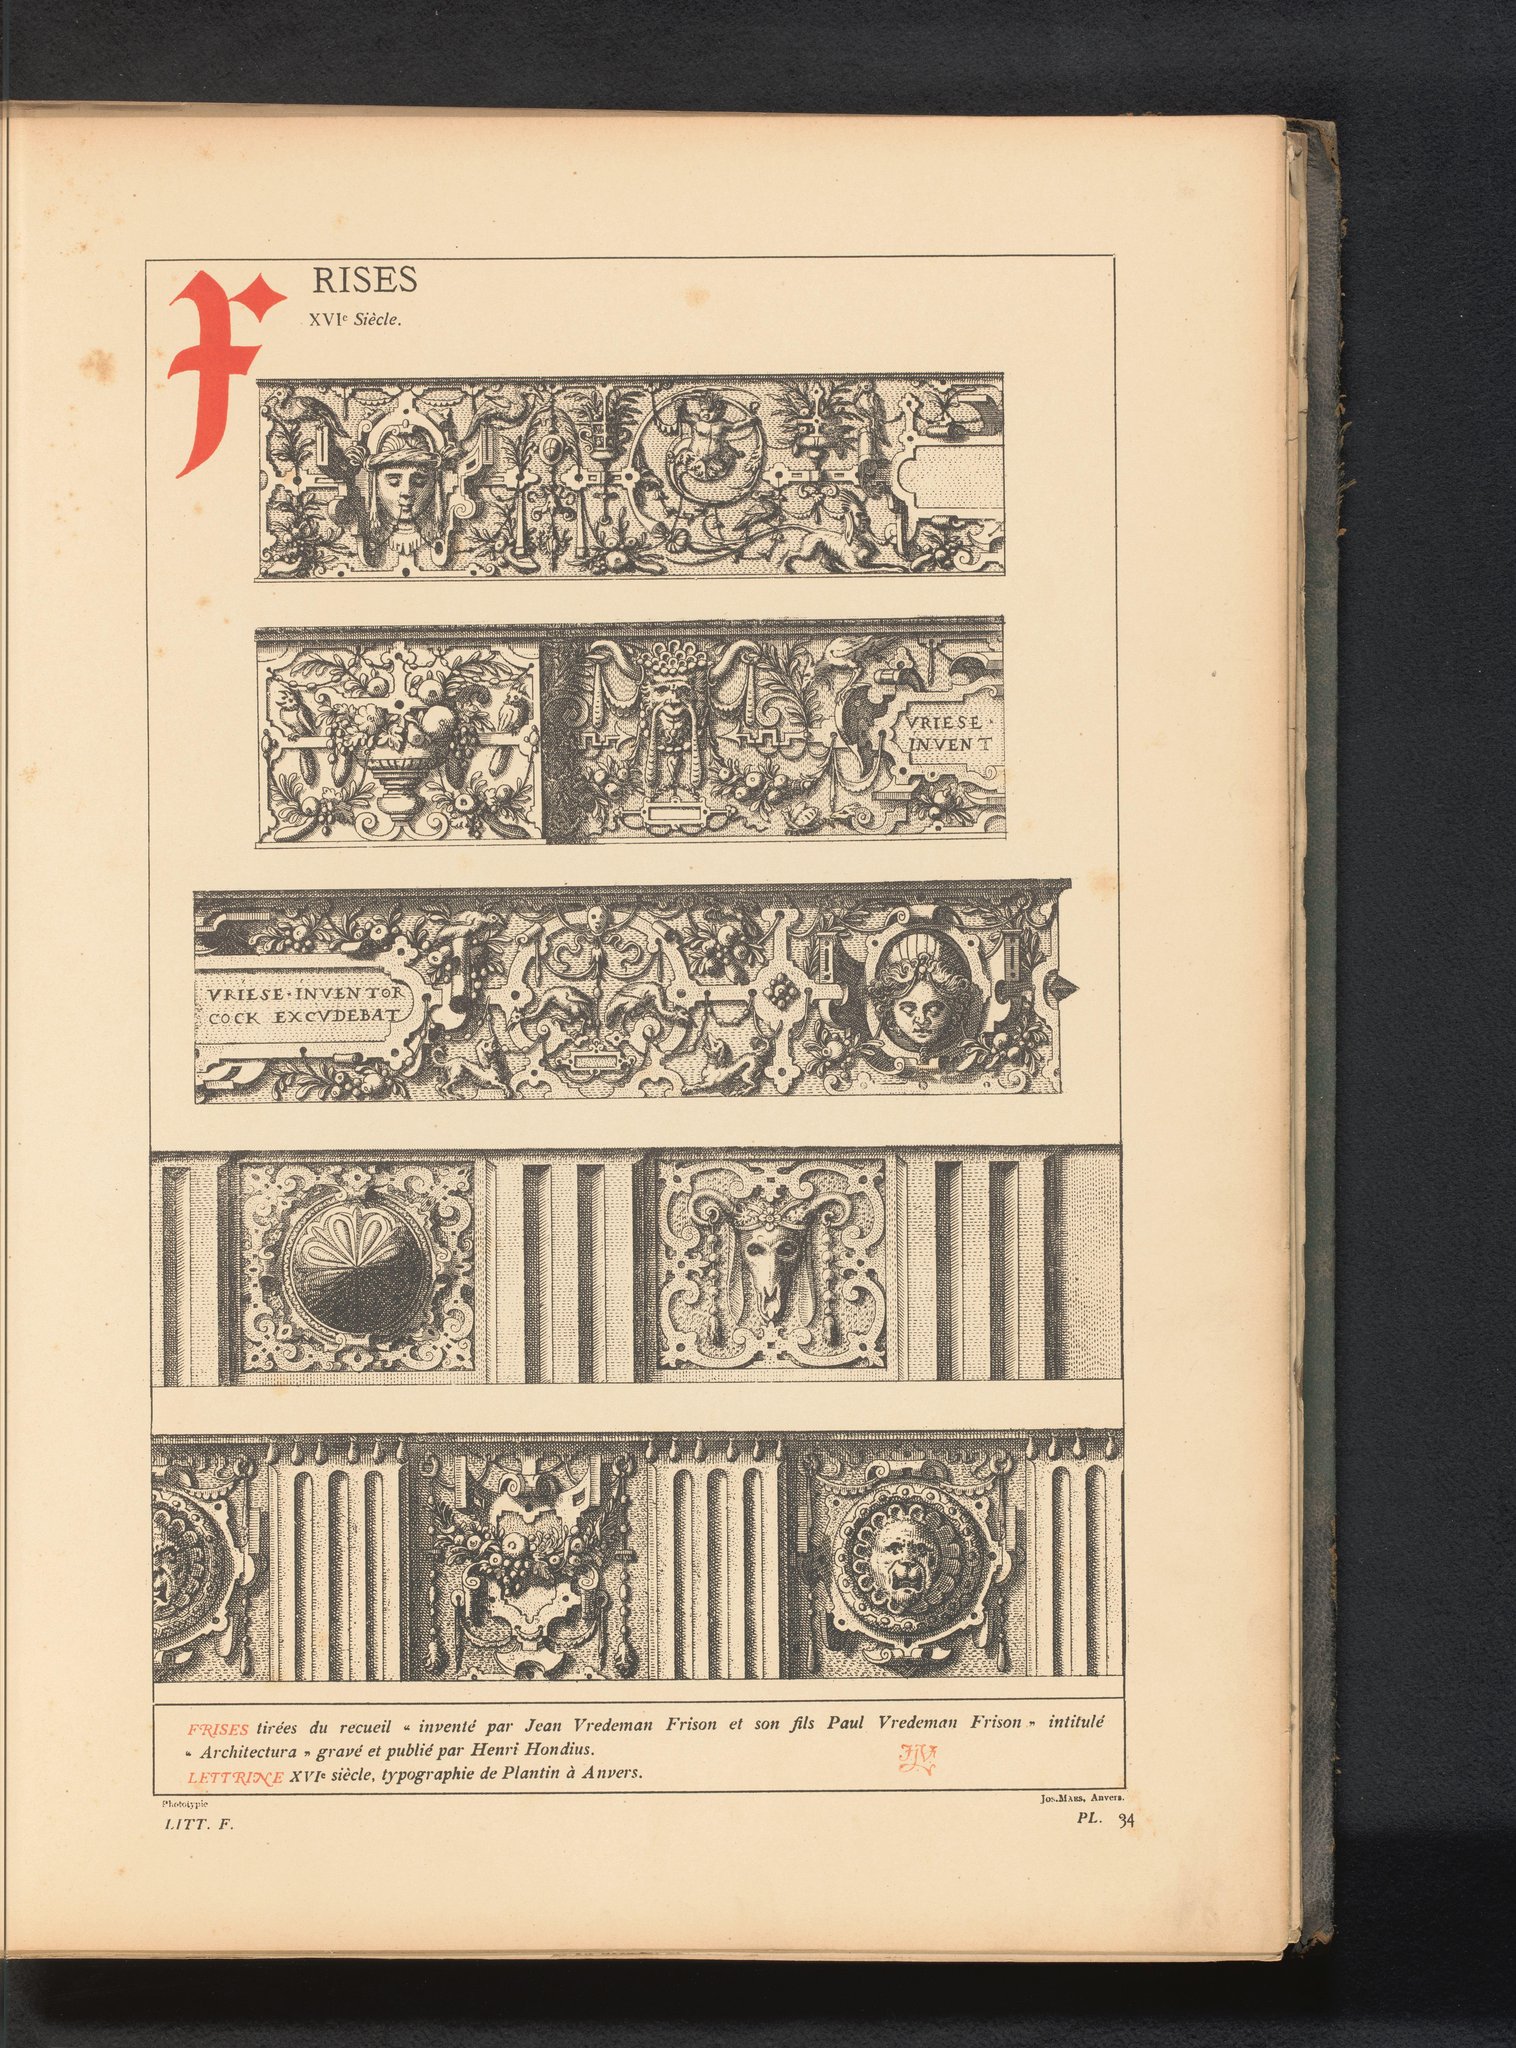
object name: page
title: Frises, XVIe Siècle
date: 1875-1880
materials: paper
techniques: photolithography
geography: antwerp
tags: mouldings ~ architecture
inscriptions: inscription: ‘FRISES tirées du (...)’, inscription: ‘LITT. F. - PL. 34.’, monogram: ‘JJvY’